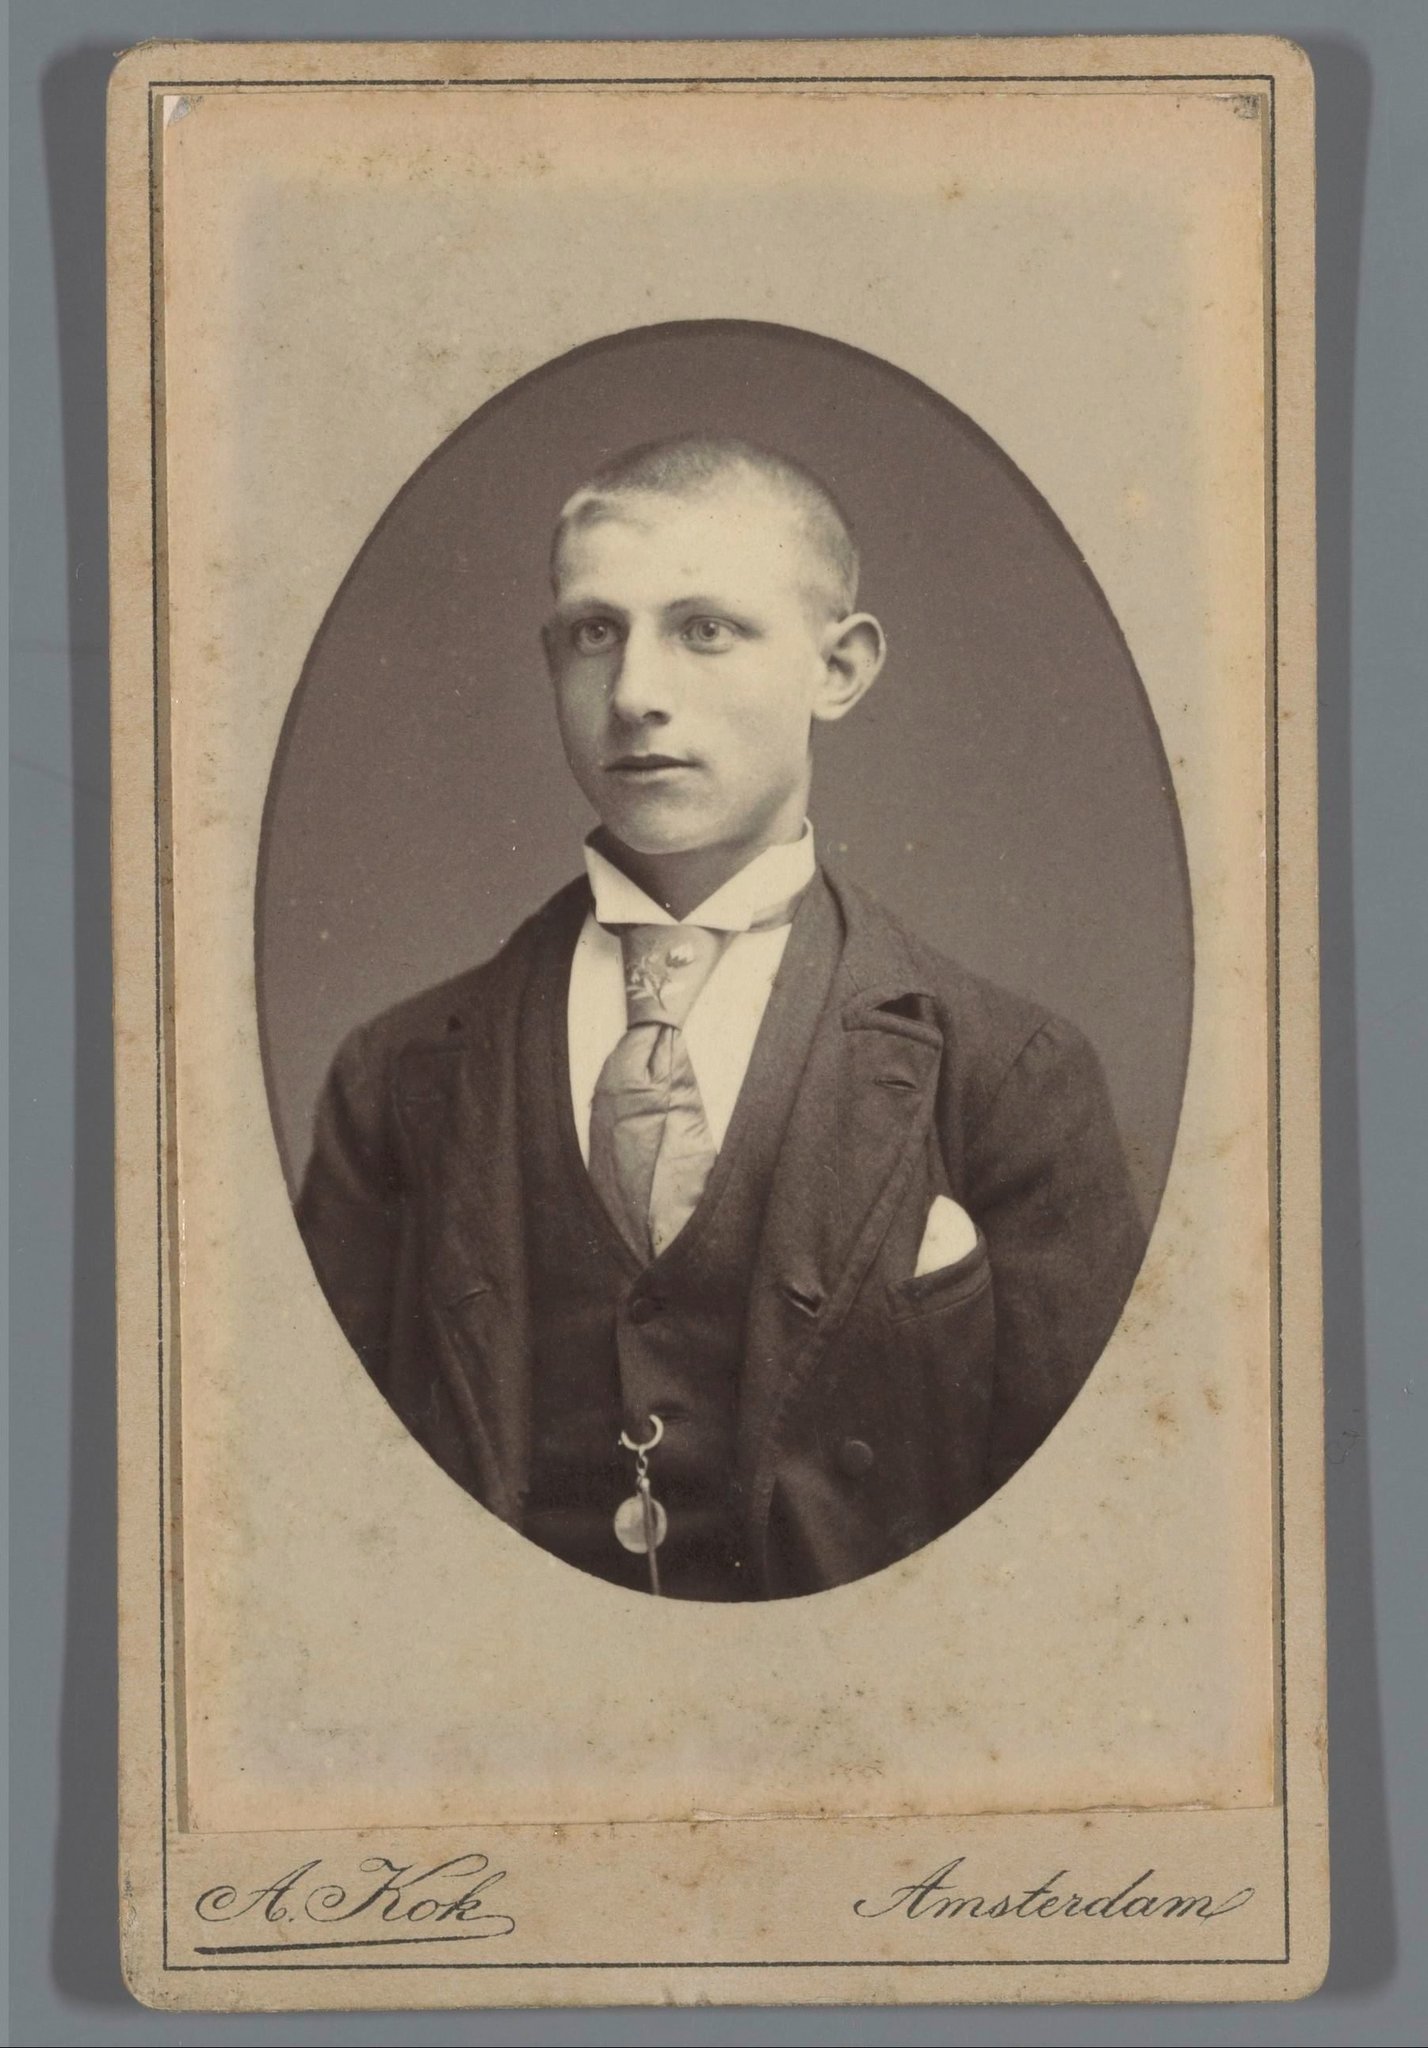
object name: photograph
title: Portret van een onbekende jongeman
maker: adrianus kok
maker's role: fotograaf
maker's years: 1852-1916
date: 1884-1910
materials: cardboard, celluloid, paper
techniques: albumen print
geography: amsterdam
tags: youth, adolescent, anonymous historical person portrayed, amsterdam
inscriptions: inscription: ‘Kattenburgergracht 5,/ het 3e huis/ van het plein,/ Amsterdam/ A. Kok/ Voor nabestelling/ wordt de plaat bewaard./ Van deze en andere portretten kunnen/ Vergrootingen gemaakt worden.’, inscription: ‘A. Kok Amsterdam’